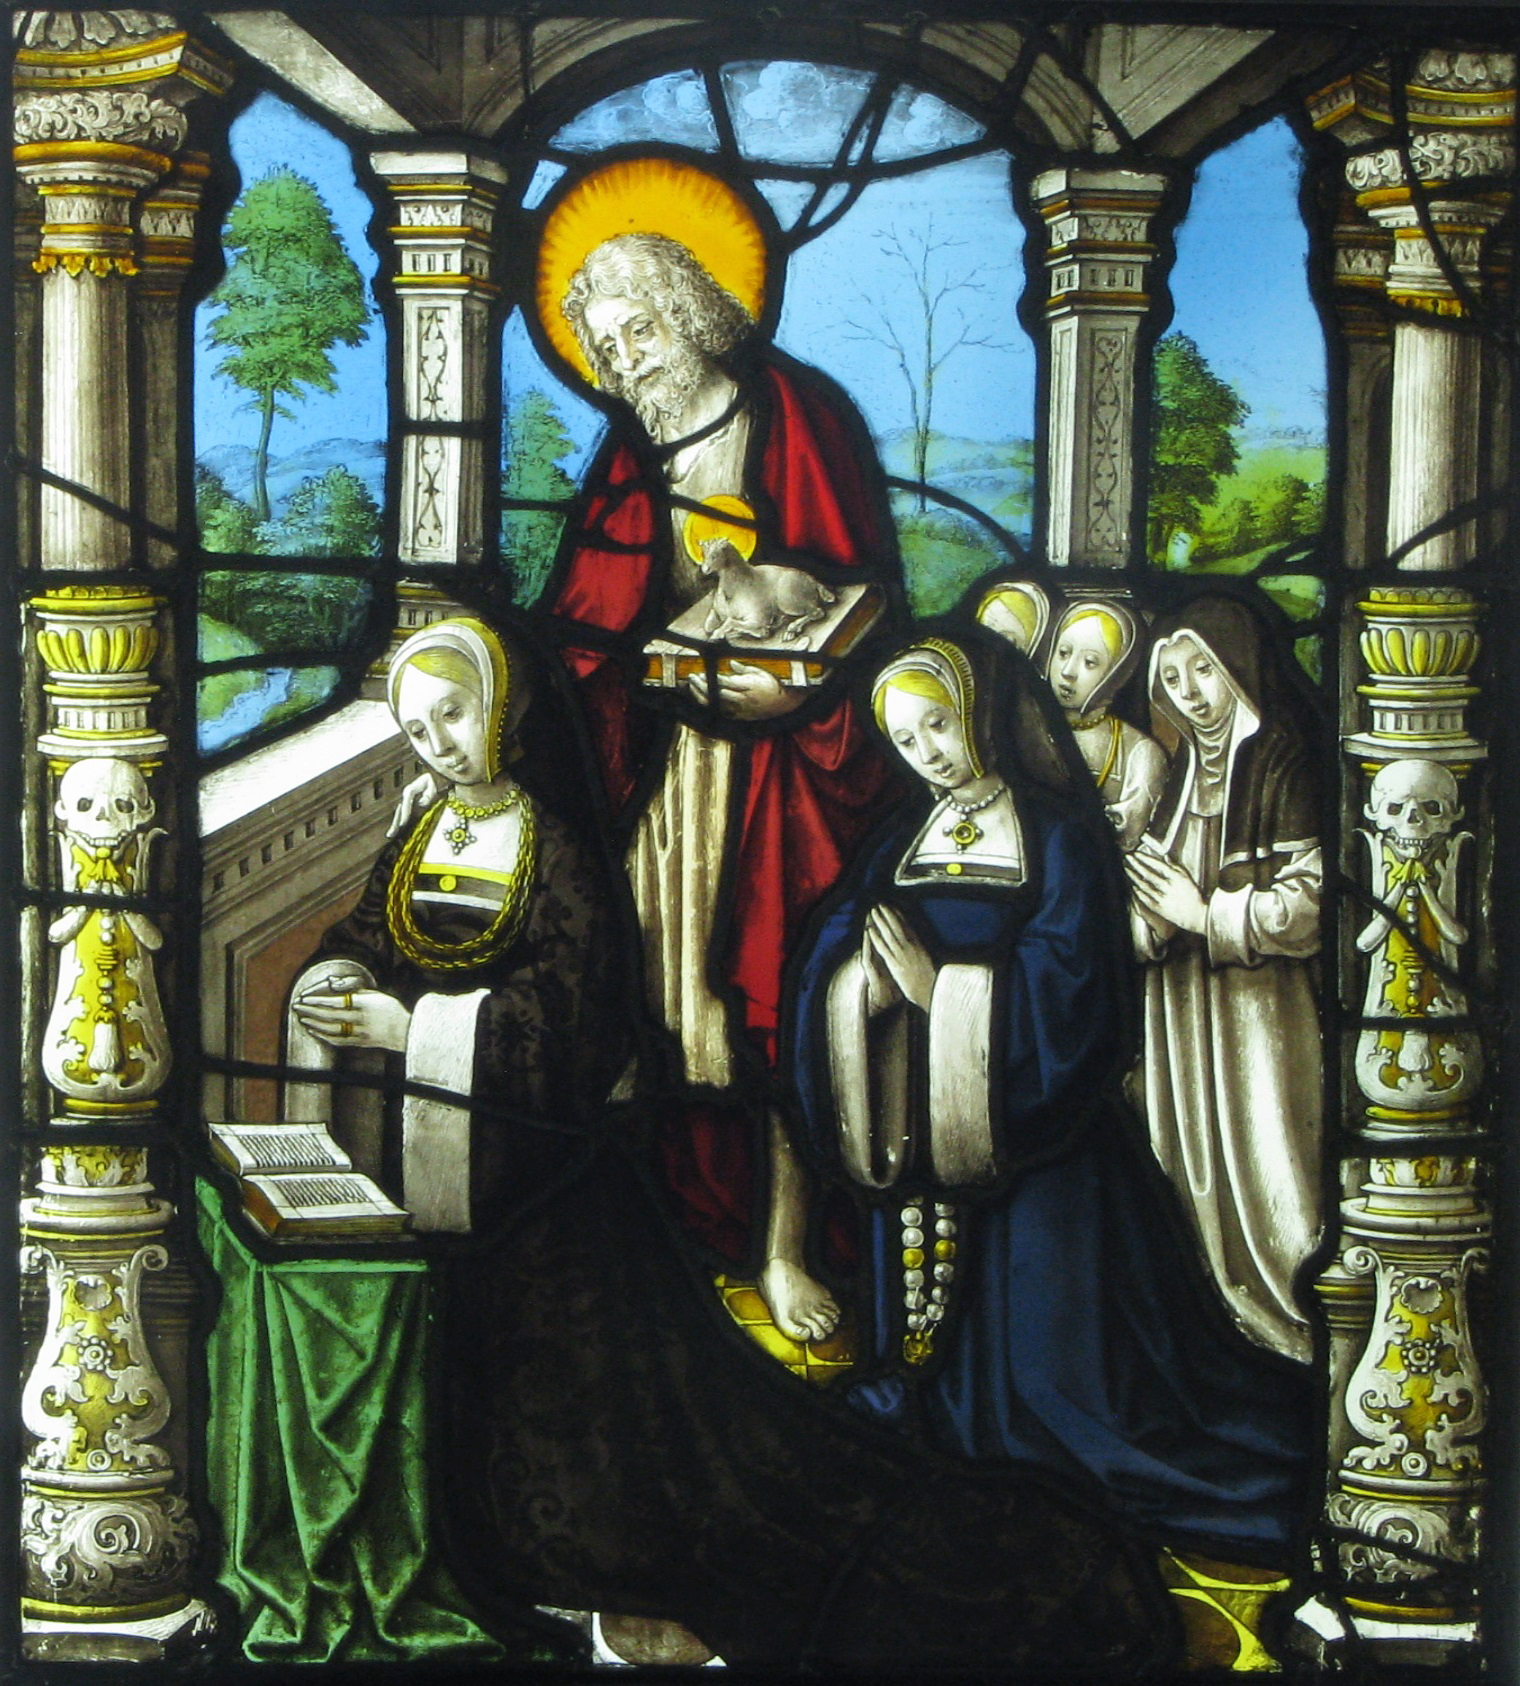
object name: panel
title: Saint John the Baptist with Five Kneeling Women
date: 1520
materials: glass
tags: women,saint john the baptist